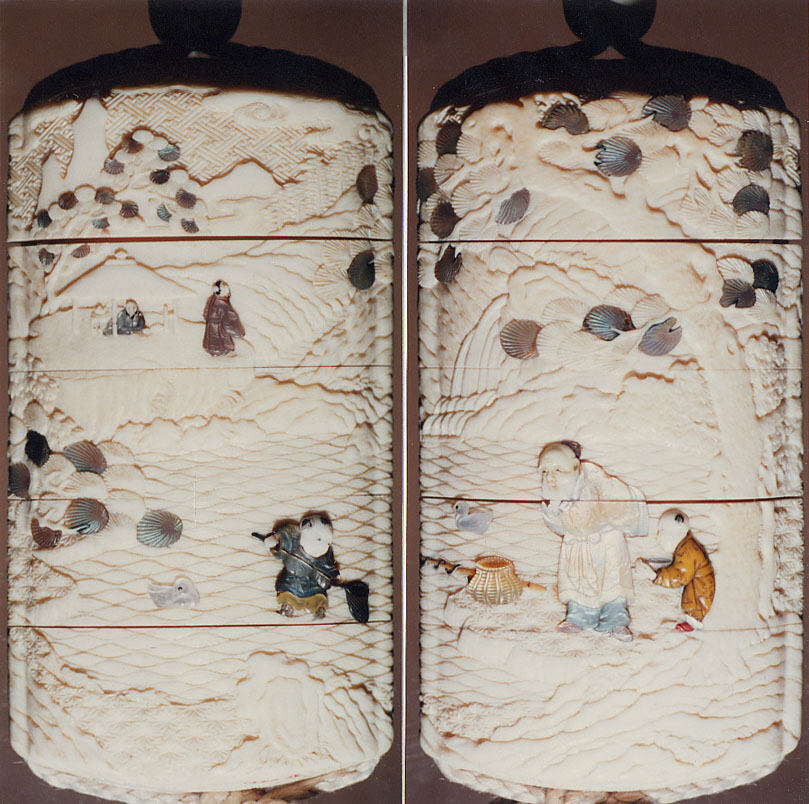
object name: inrō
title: Case (Inrō) with Design of Chinese Sage and Karako beneath Pine Tree at Shore (obverse); Karako Fishing (reverse)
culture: japanese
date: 1867-1900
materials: horn, ivory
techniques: carving, relief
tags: men,fishing,shells